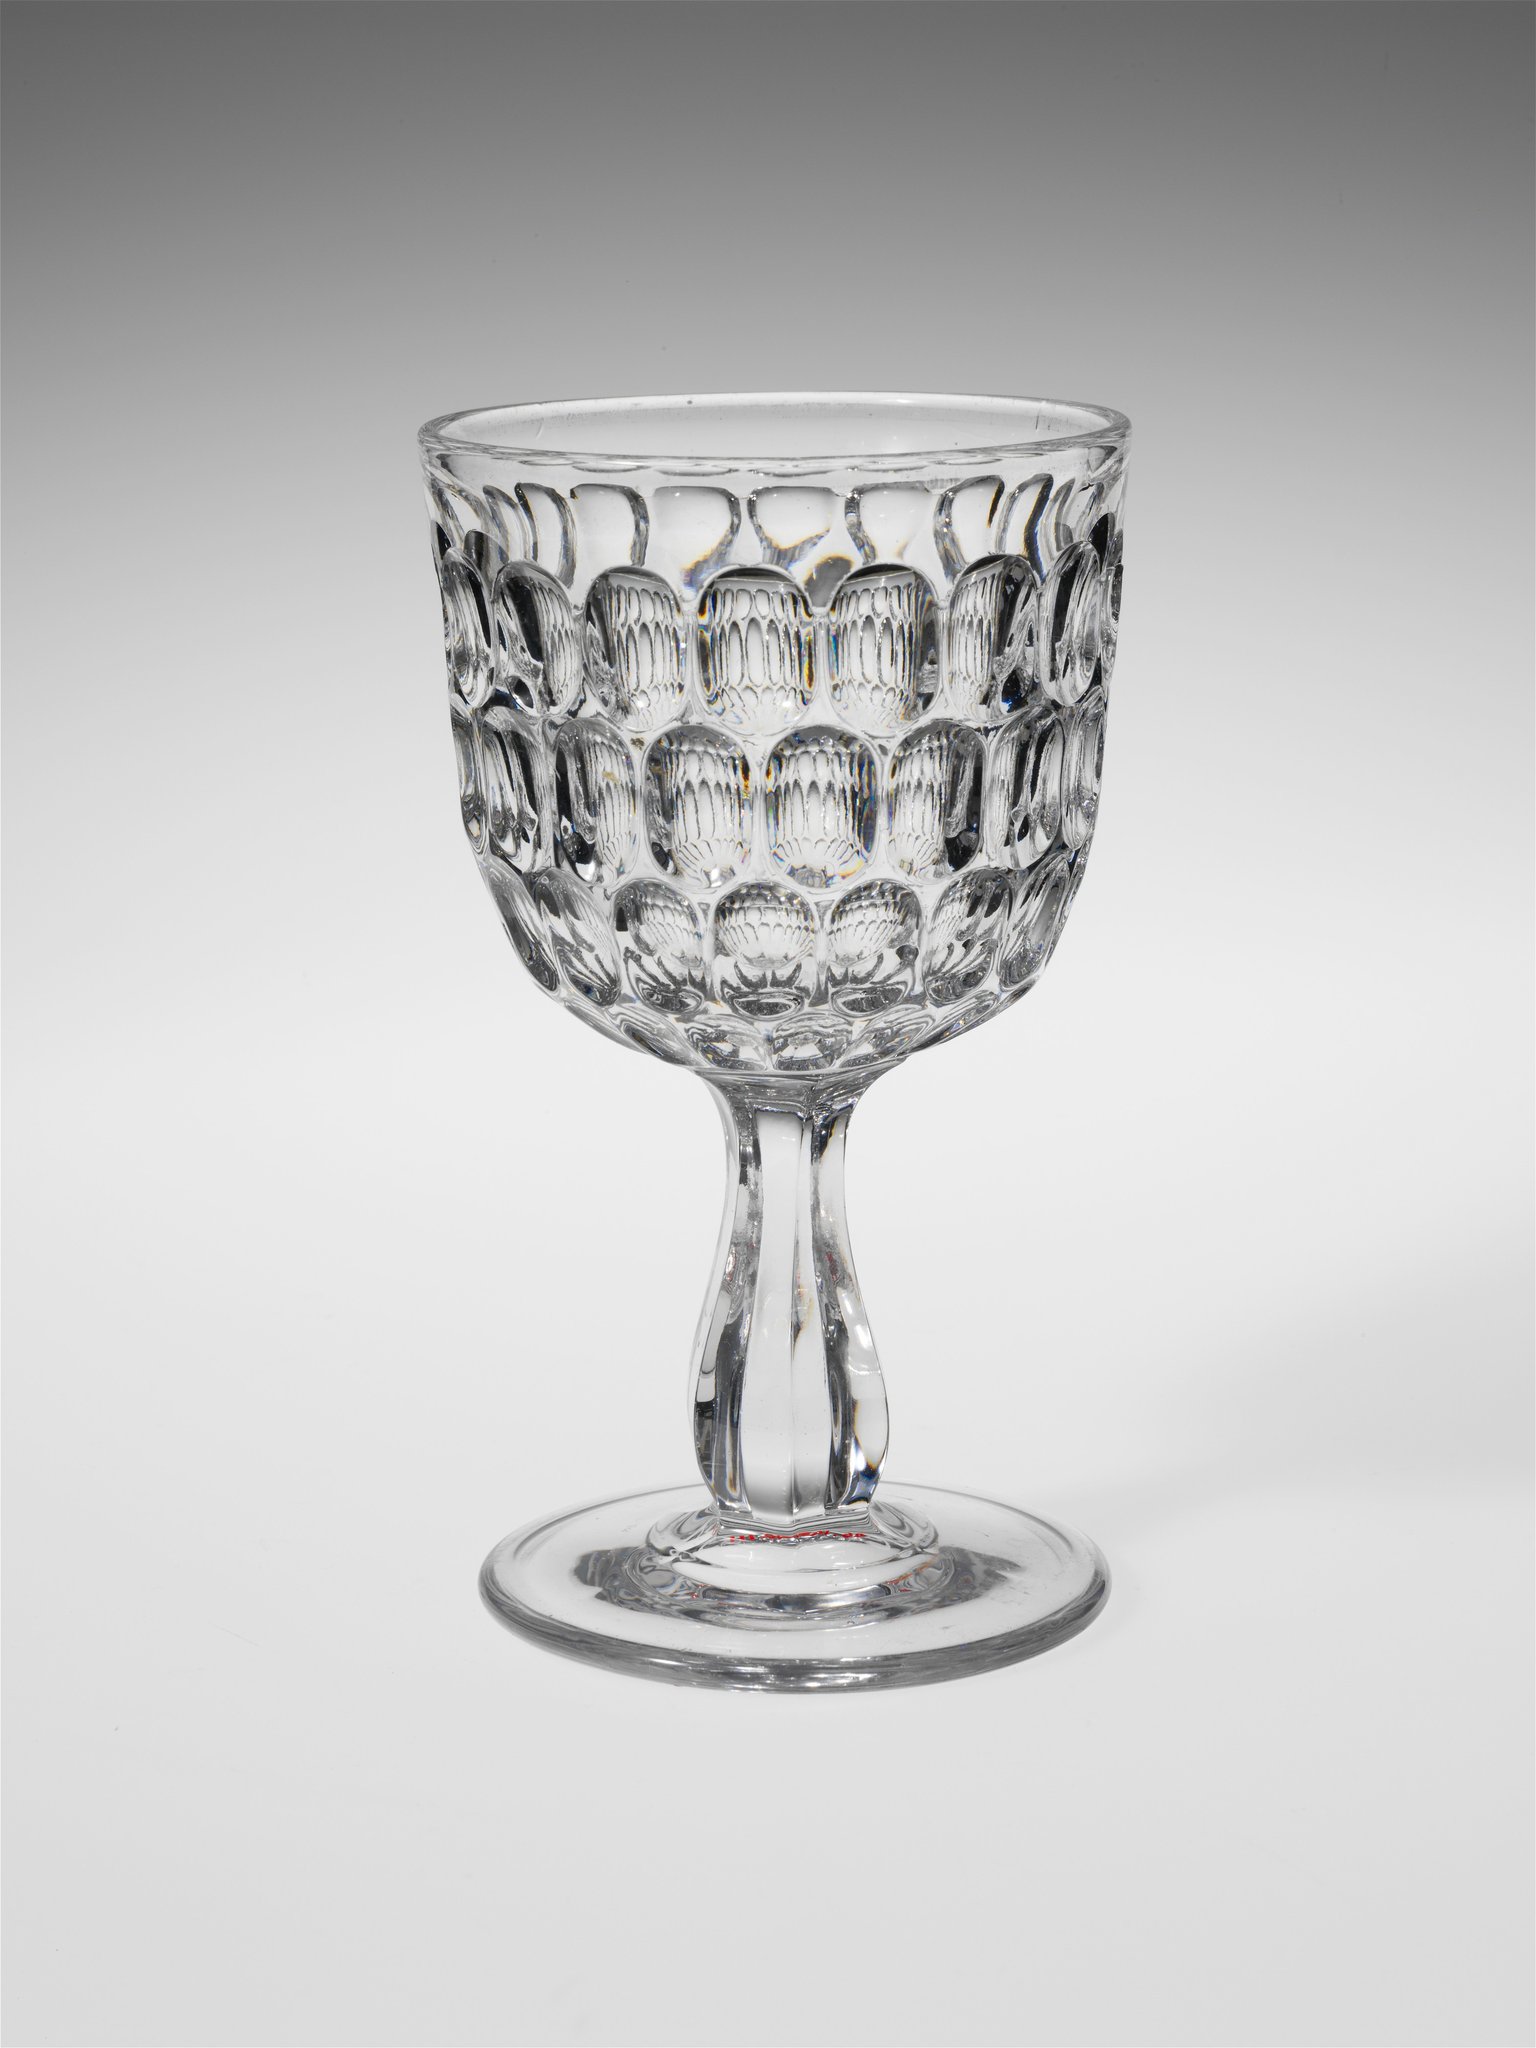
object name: goblet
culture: american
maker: bakewell, pears and company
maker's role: maker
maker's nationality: american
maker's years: 1836-1882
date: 1850-1870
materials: glass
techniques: pressed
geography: united states